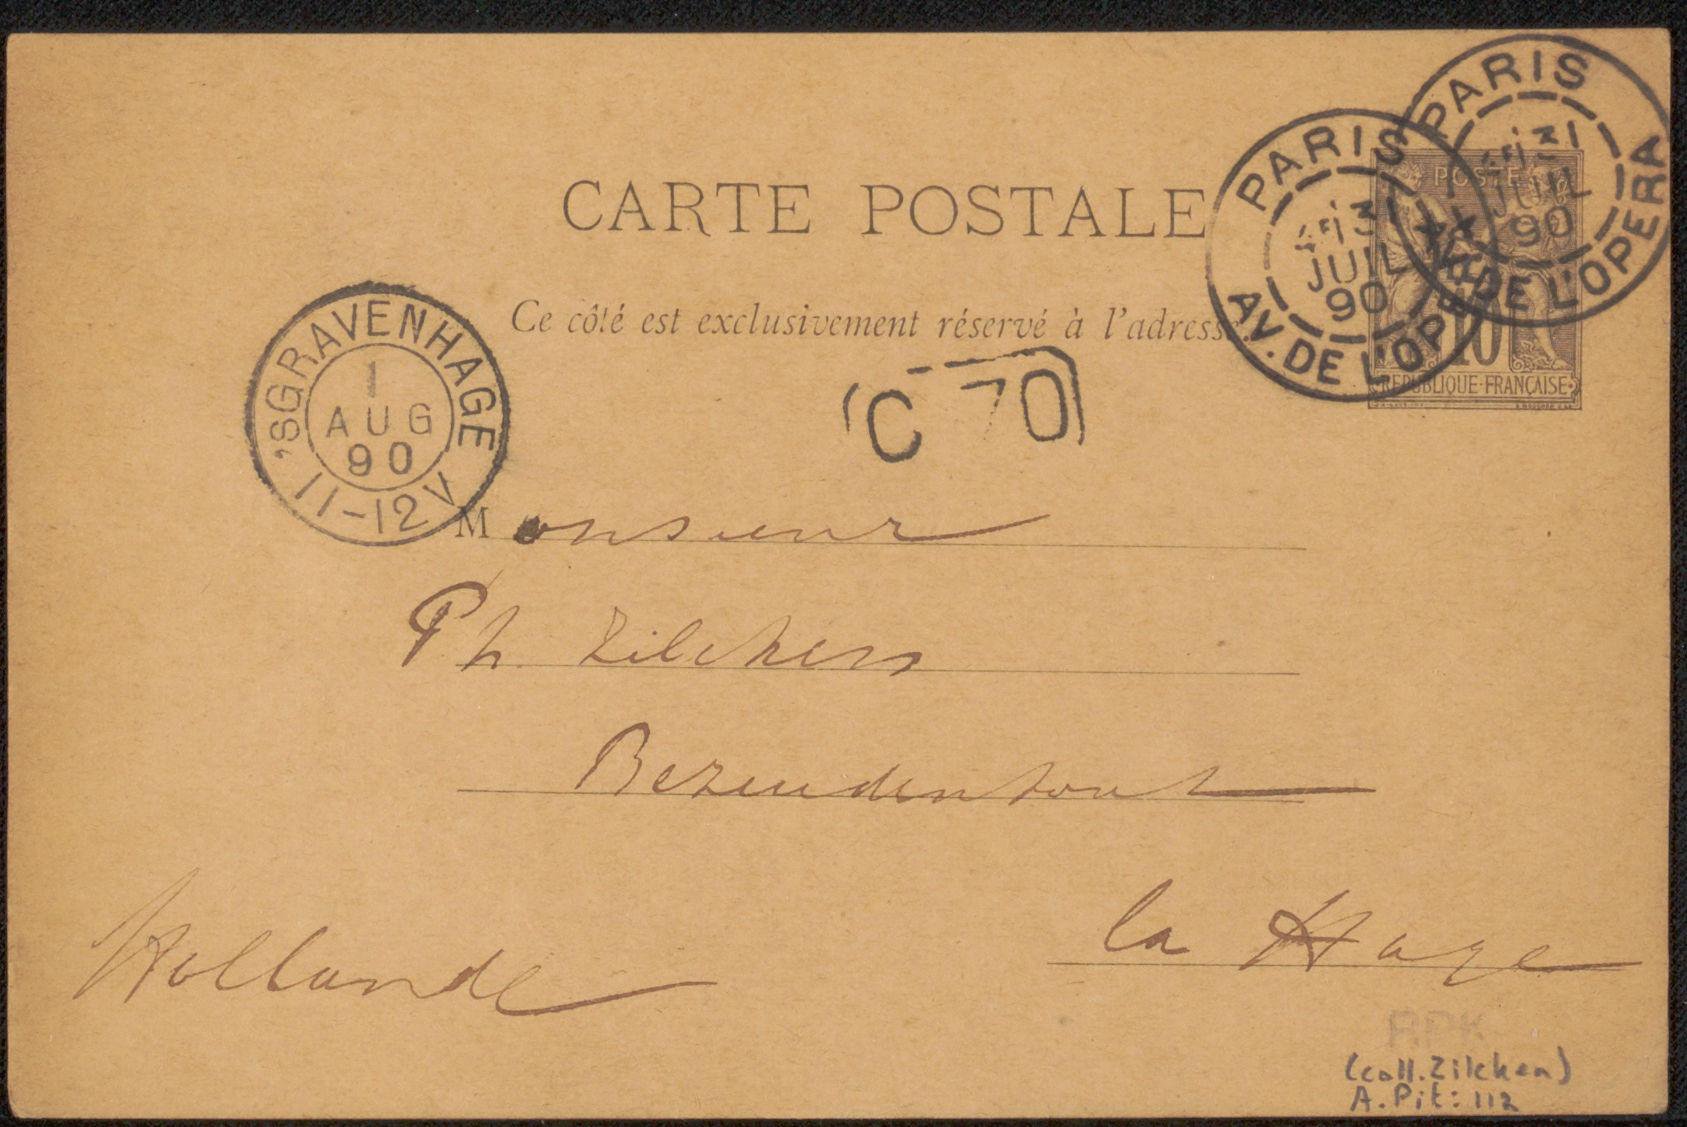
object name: postcard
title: Briefkaart aan Philip Zilcken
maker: adriaan pit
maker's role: print maker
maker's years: 1860-1944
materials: cardboard, ink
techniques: pen, writing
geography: paris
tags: the hague, painter, draughtsman, marinus van der maarel, philip zilcken, money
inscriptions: collector's mark: ‘RPK’